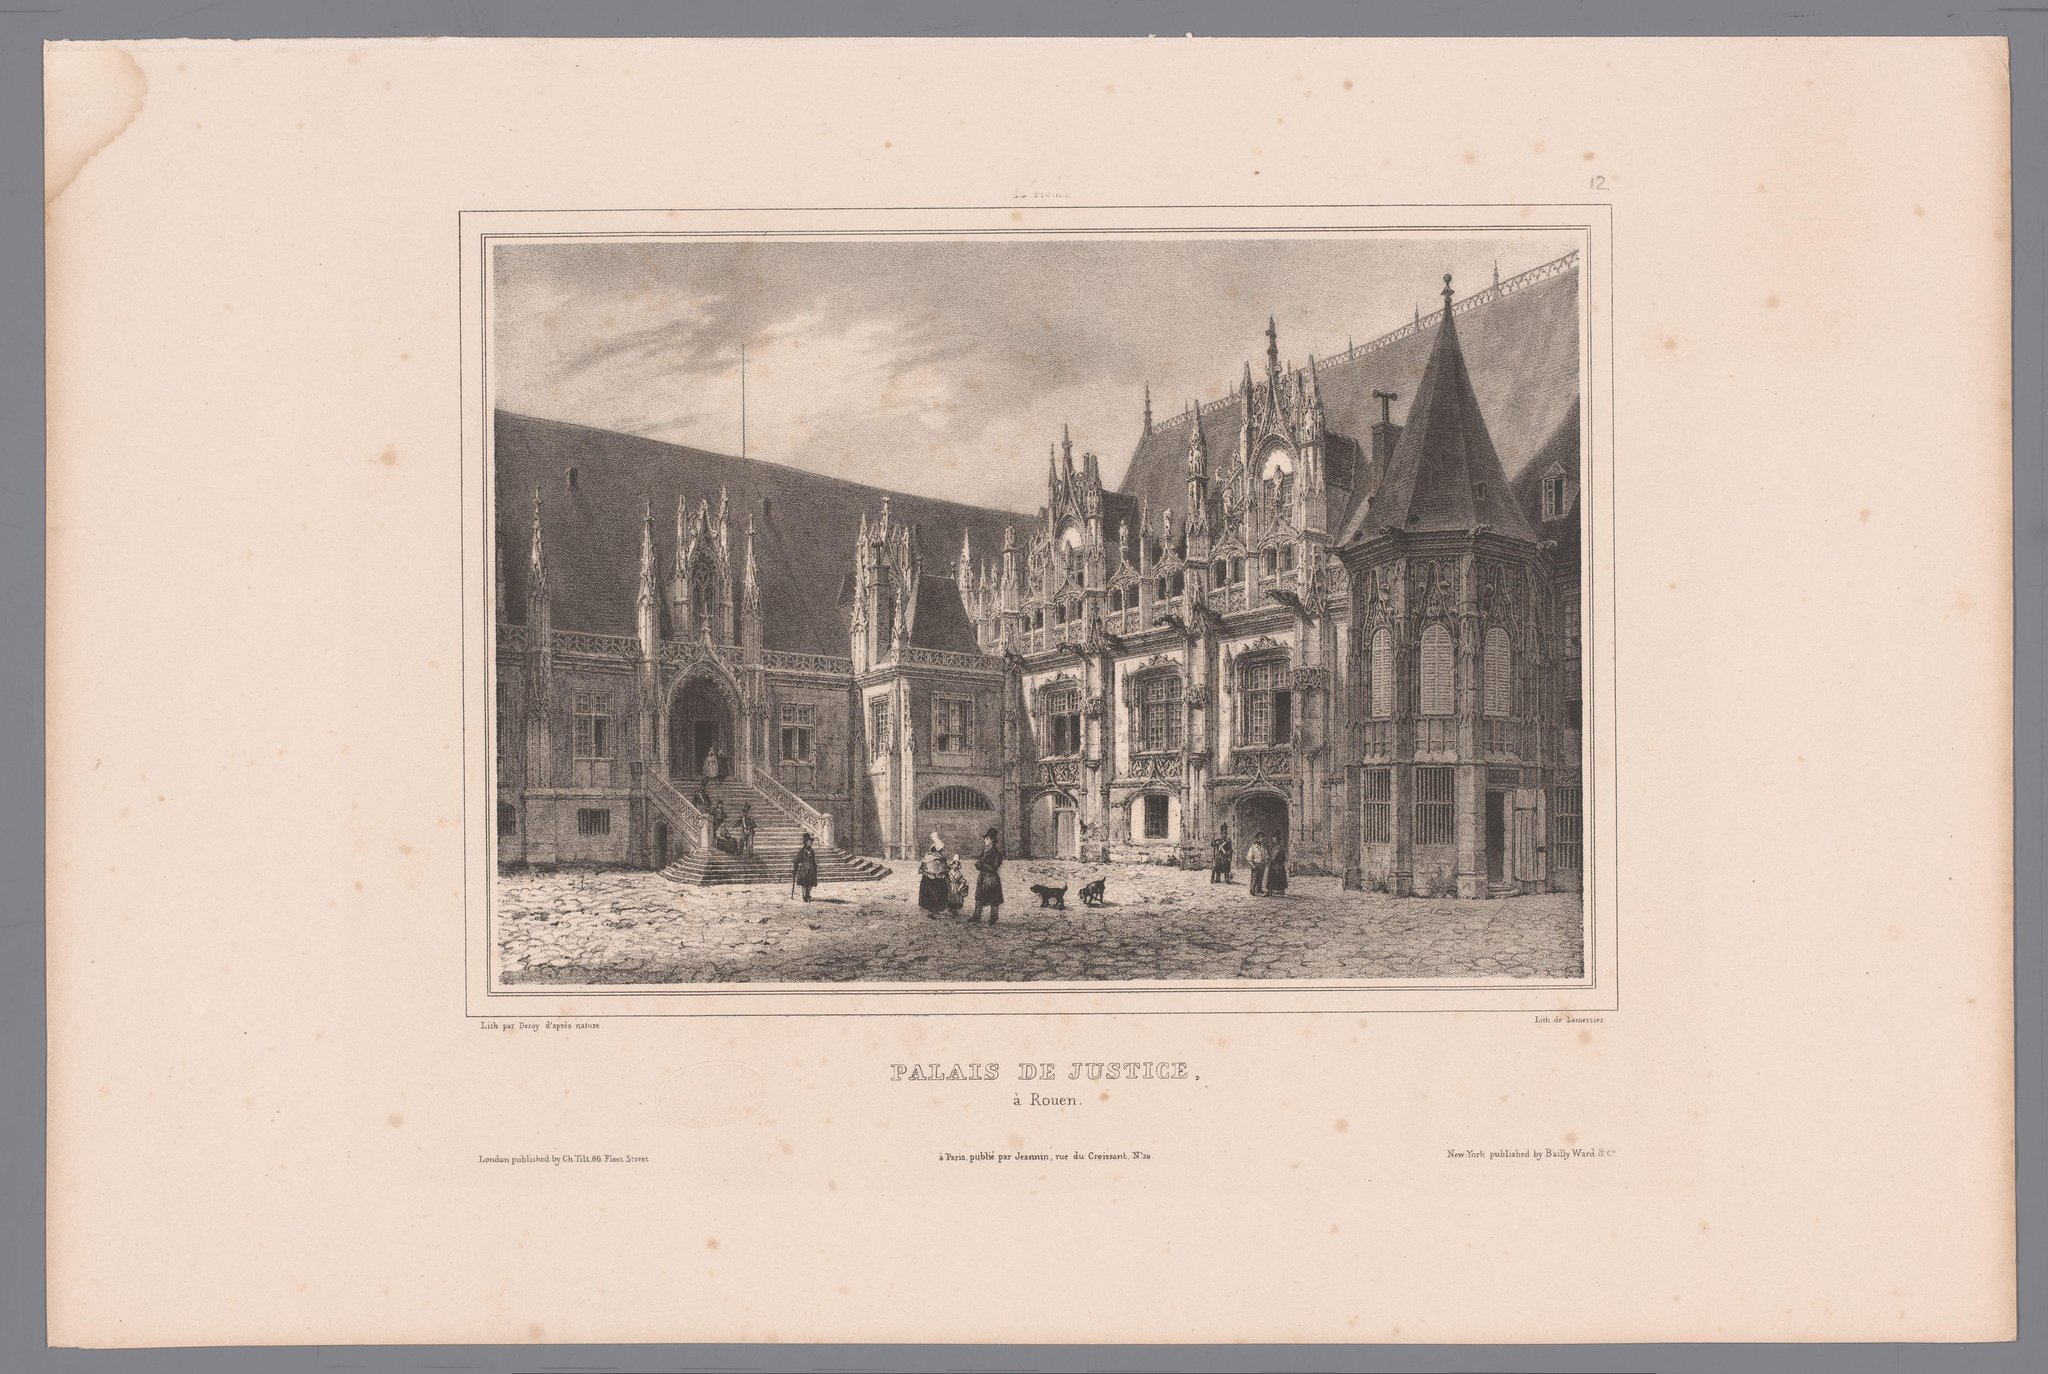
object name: print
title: Gezichten in Frankrijk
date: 1834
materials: paper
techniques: lithograph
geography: paris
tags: court building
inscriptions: collector's mark: Lugt 2228a, check stamp: Lugt 1397c